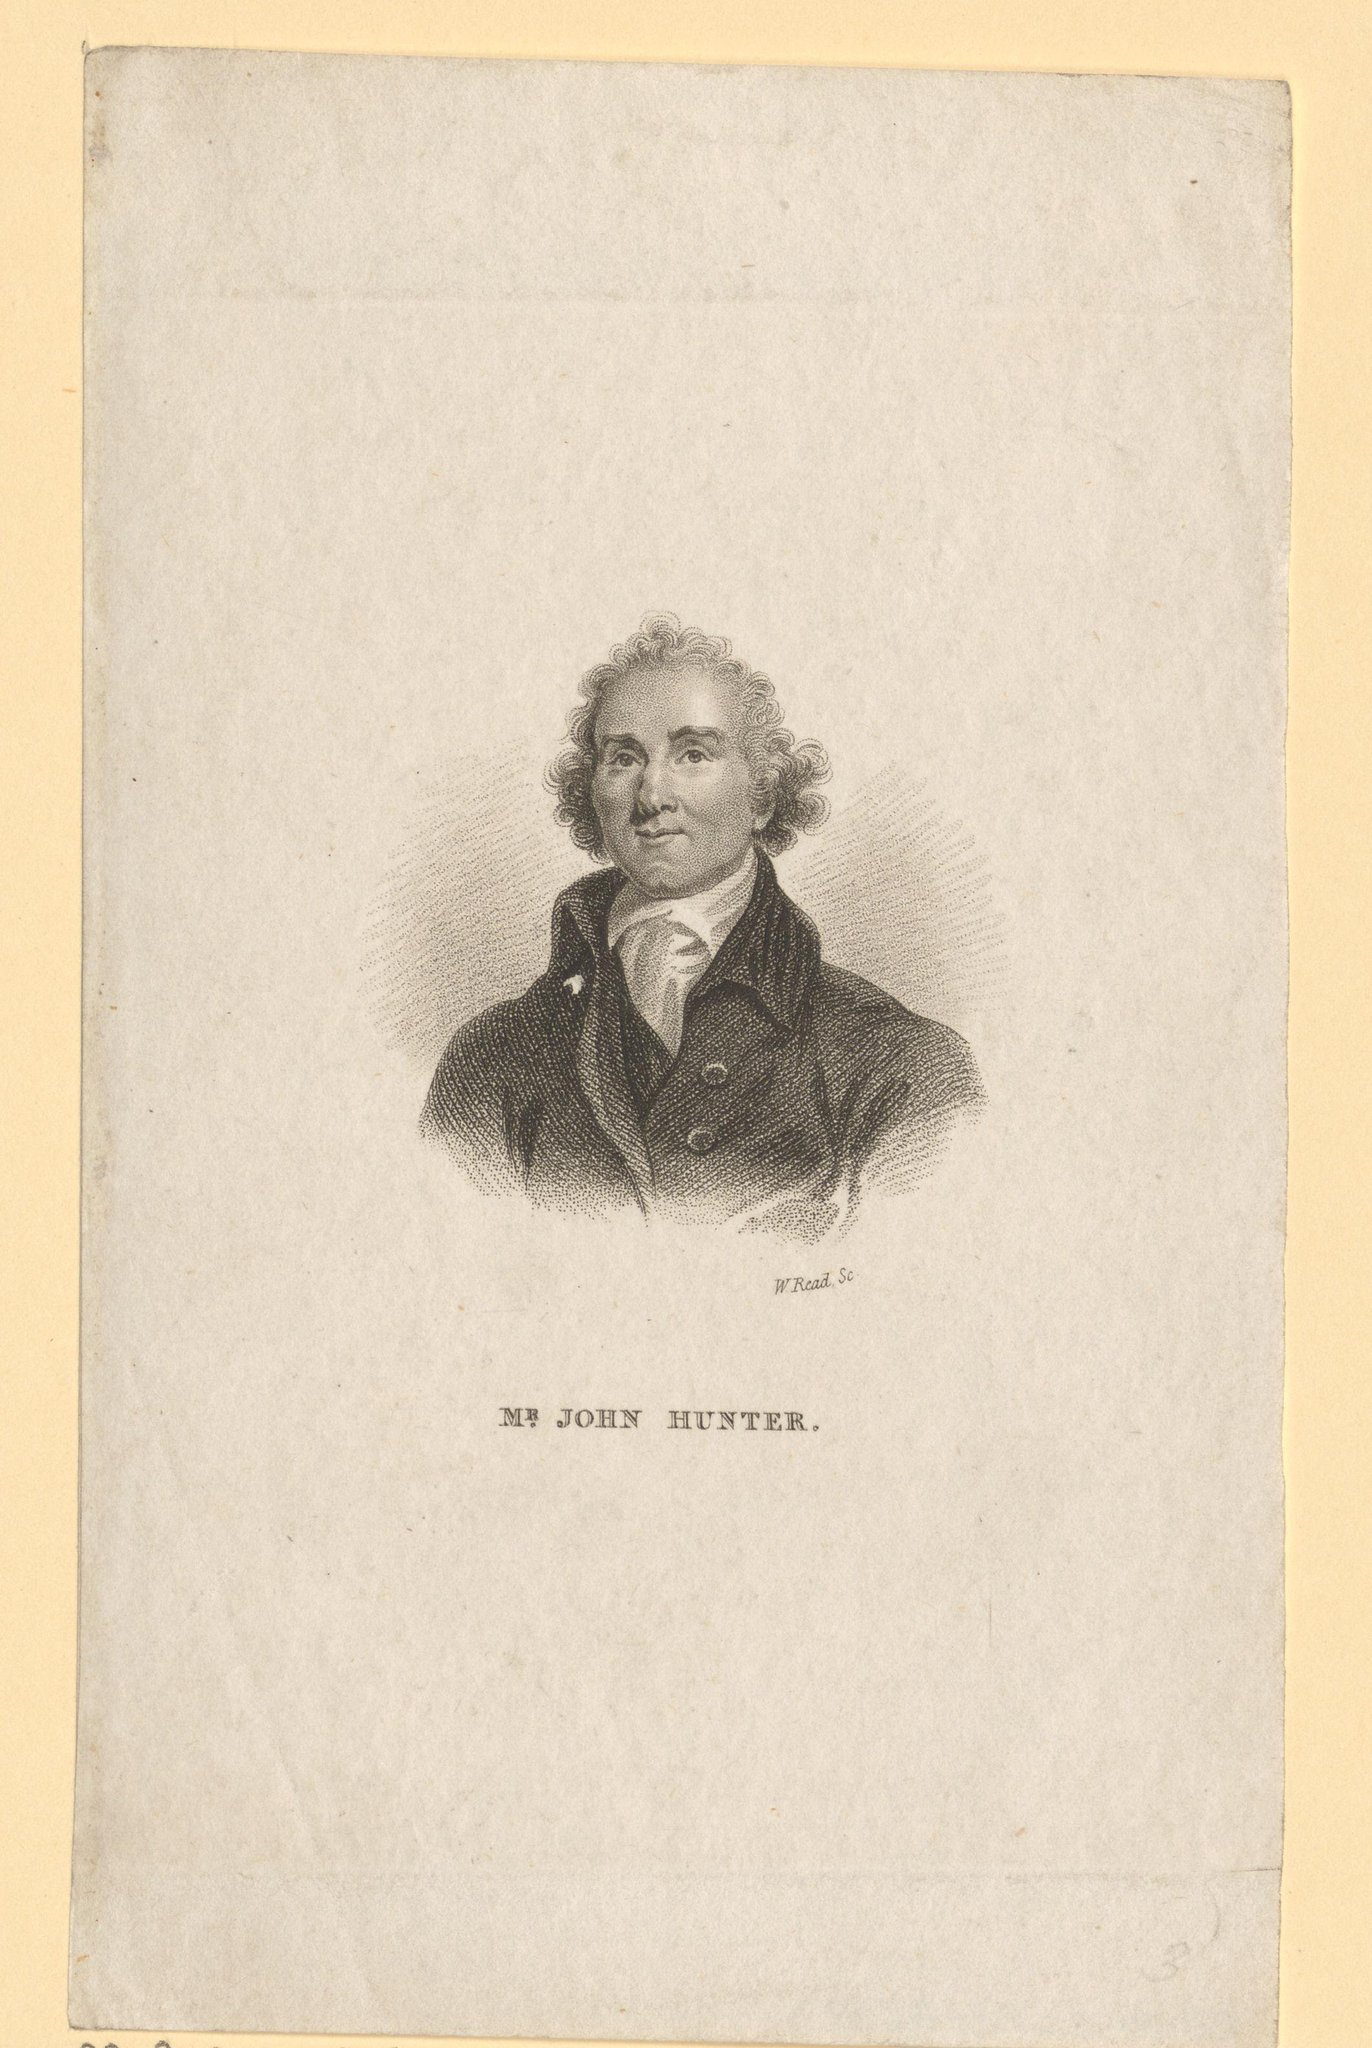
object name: print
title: Portret van John Hunter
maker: w. read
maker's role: print maker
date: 1824-1837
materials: paper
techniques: etching, roulette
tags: historical persons, physician, doctor